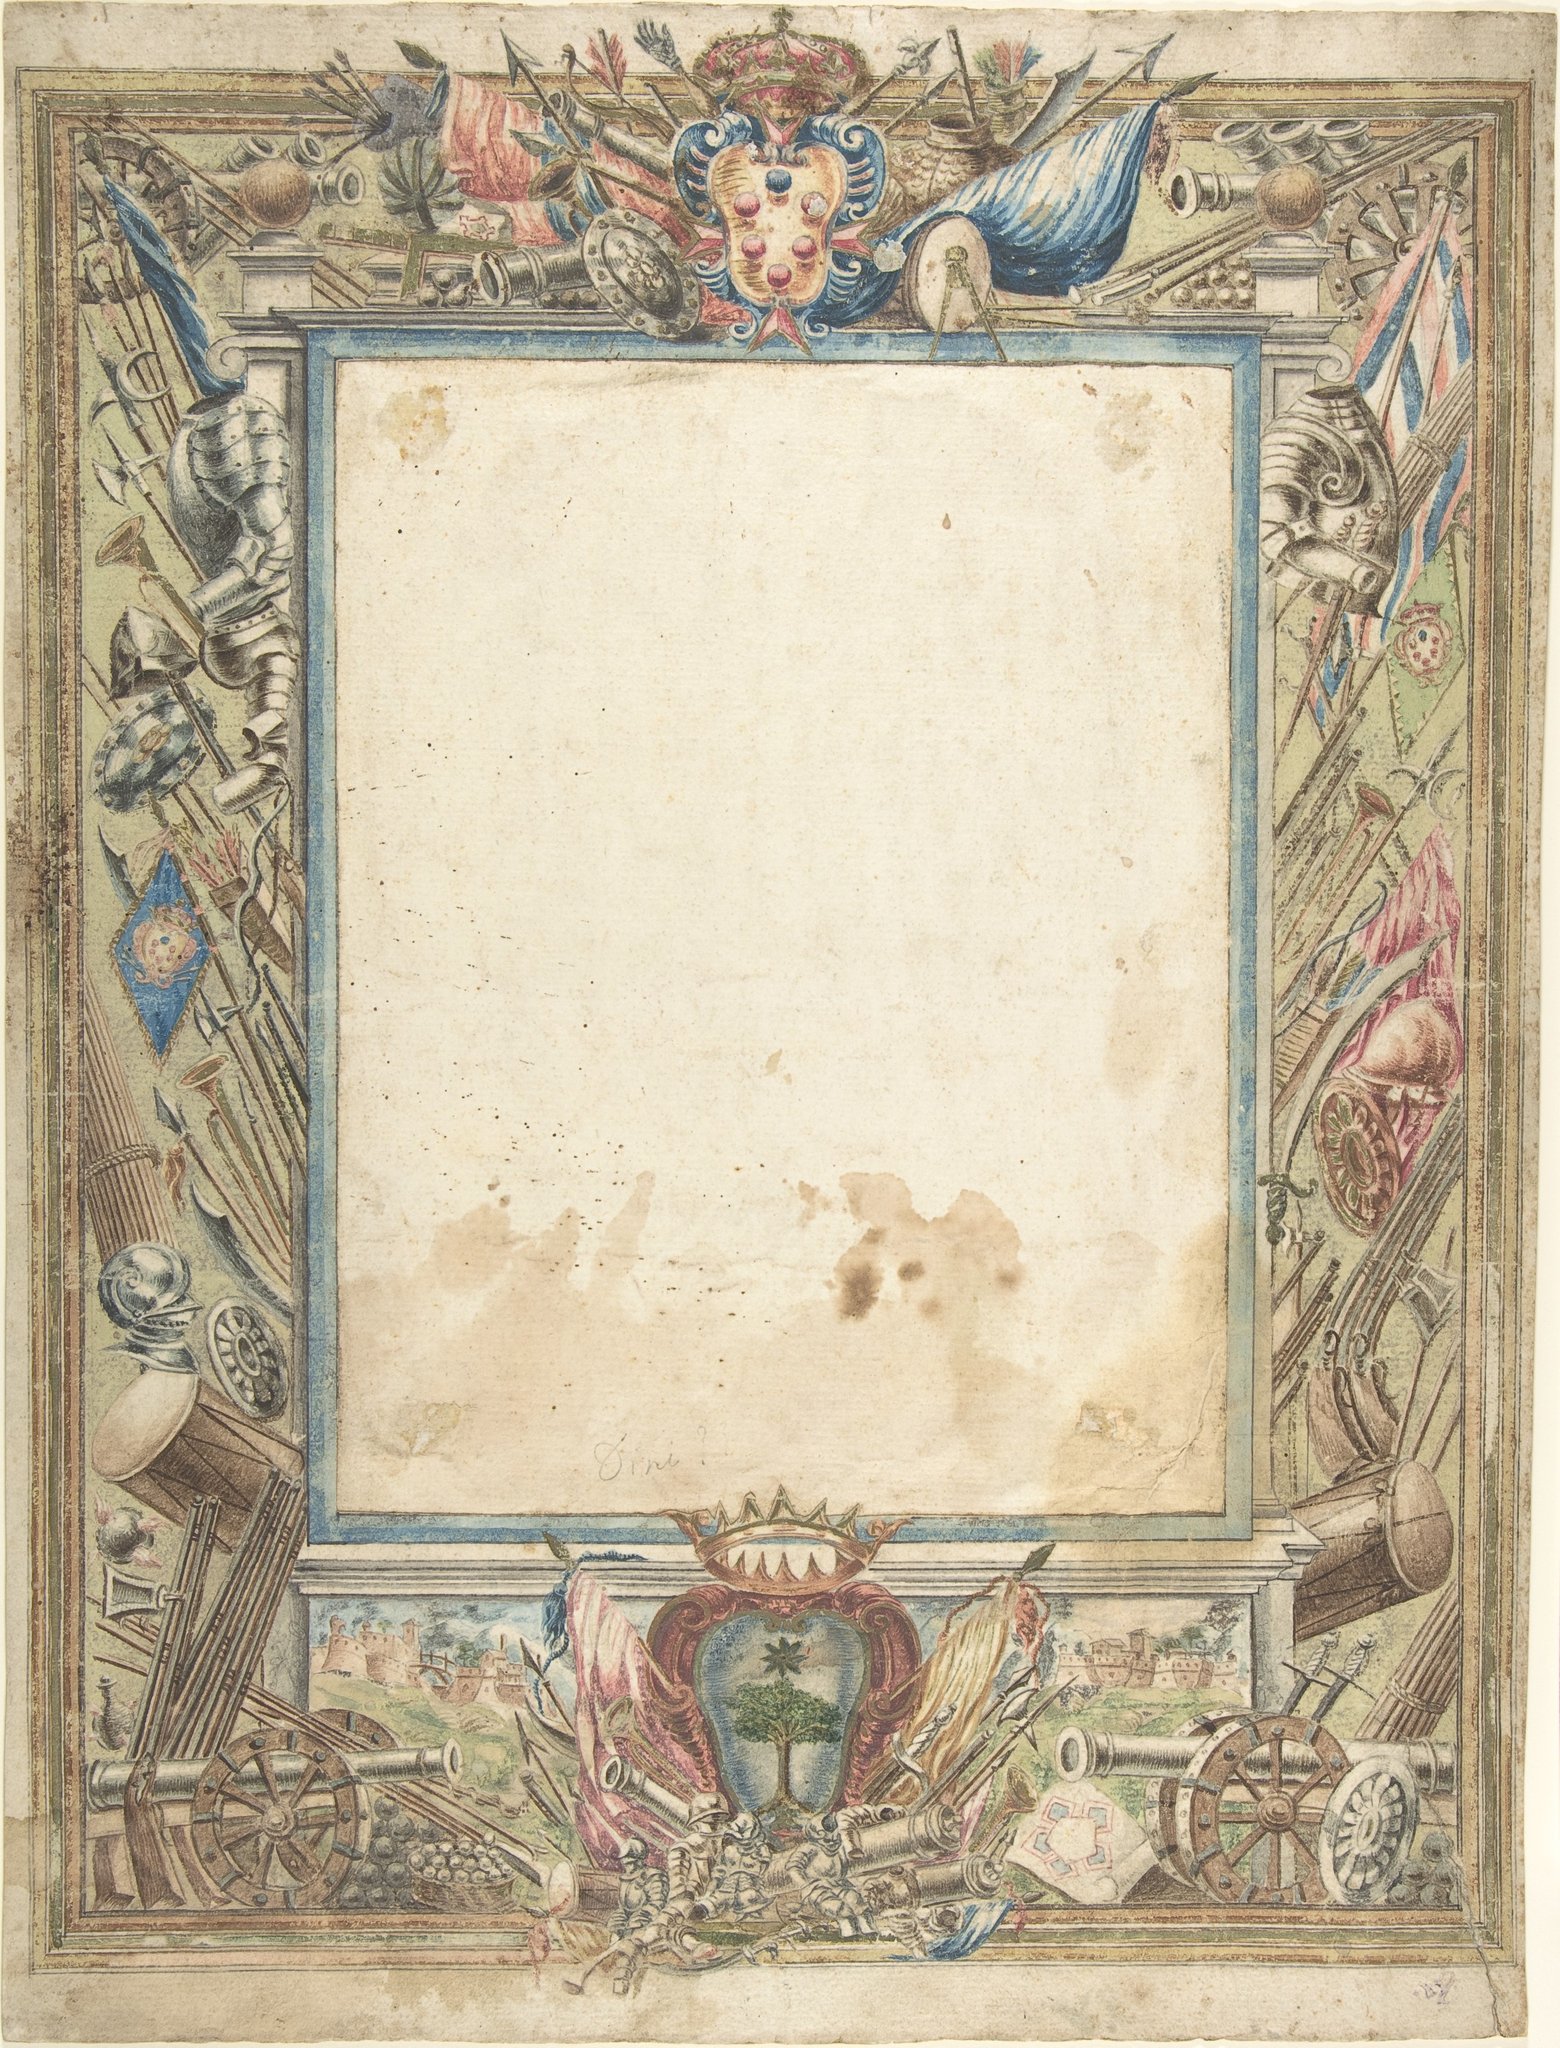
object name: drawing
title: Design for a Frame with Armorial Trophies, the Medici Coat of Arms and a Second Coat of Arms, possibly of the Alberighi Family (?)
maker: anonymous, italian, 16th century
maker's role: artist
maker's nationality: italian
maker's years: 1550-1600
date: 1501-1600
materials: ink, watercolor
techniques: pen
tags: cannons,coat of arms